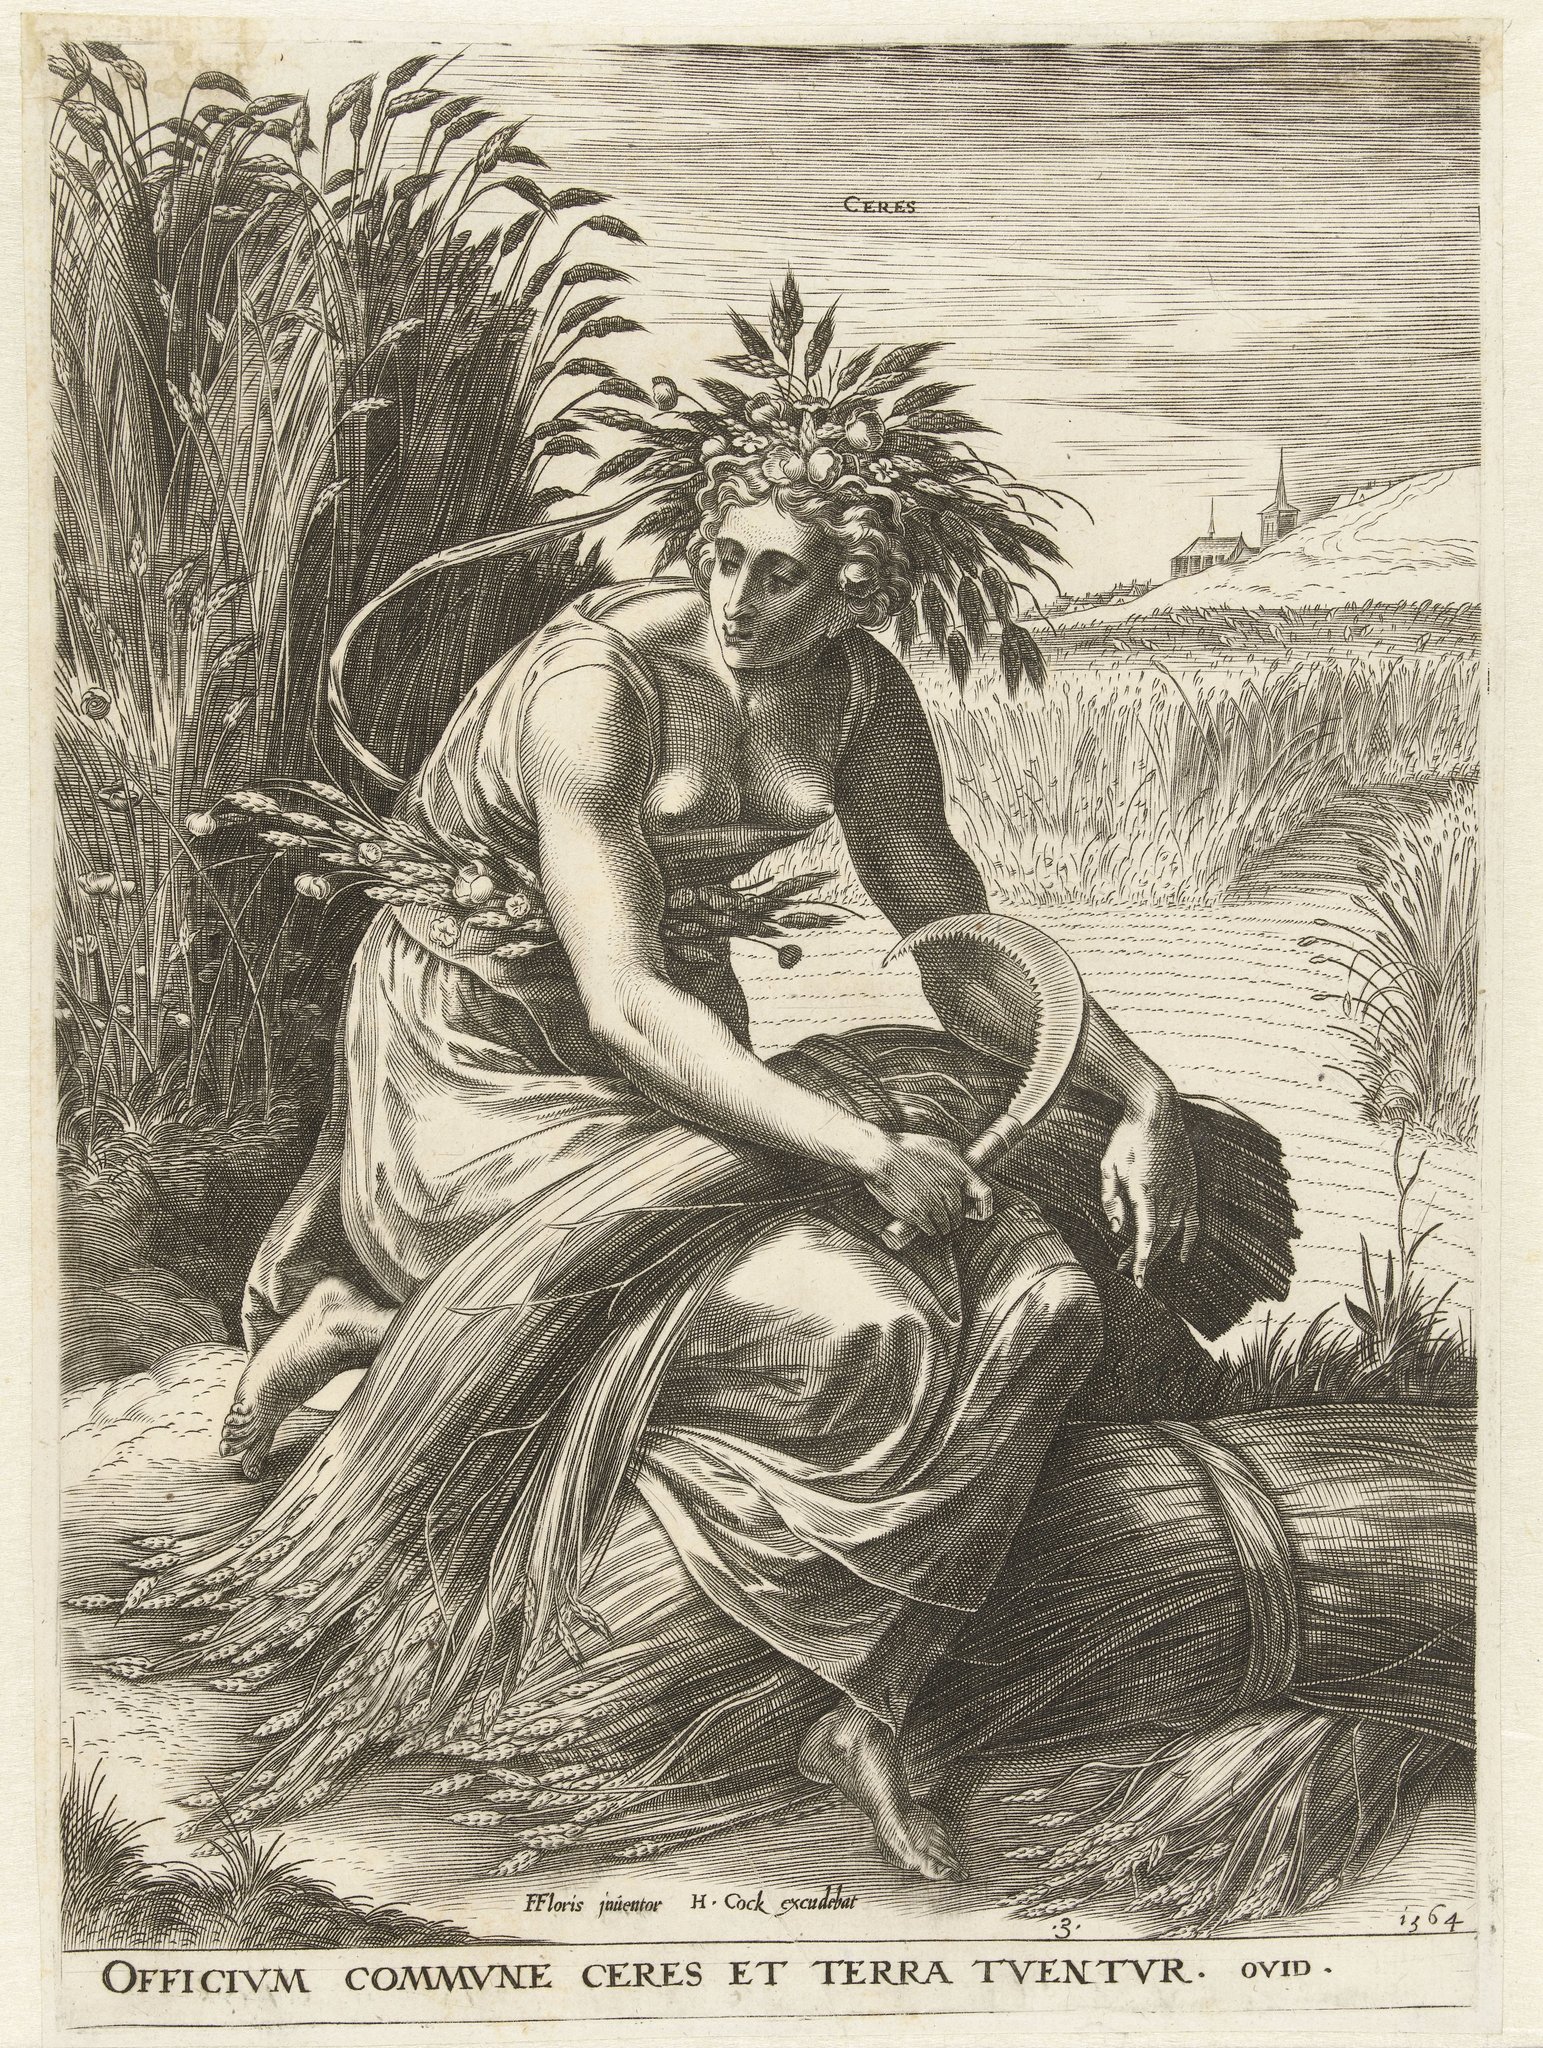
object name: print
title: Godinnen en nimfen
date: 1564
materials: paper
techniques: engraving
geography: antwerp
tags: (story of) ceres (demeter)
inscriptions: collector's mark: Lugt 2542, collector's mark: Lugt 1379, collector's mark: Lugt 2228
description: Ceres de godin van de akkerbouw bij de graanoogst. Ceres knielt bij een hoop met korenaren met een sikkel in de hand.